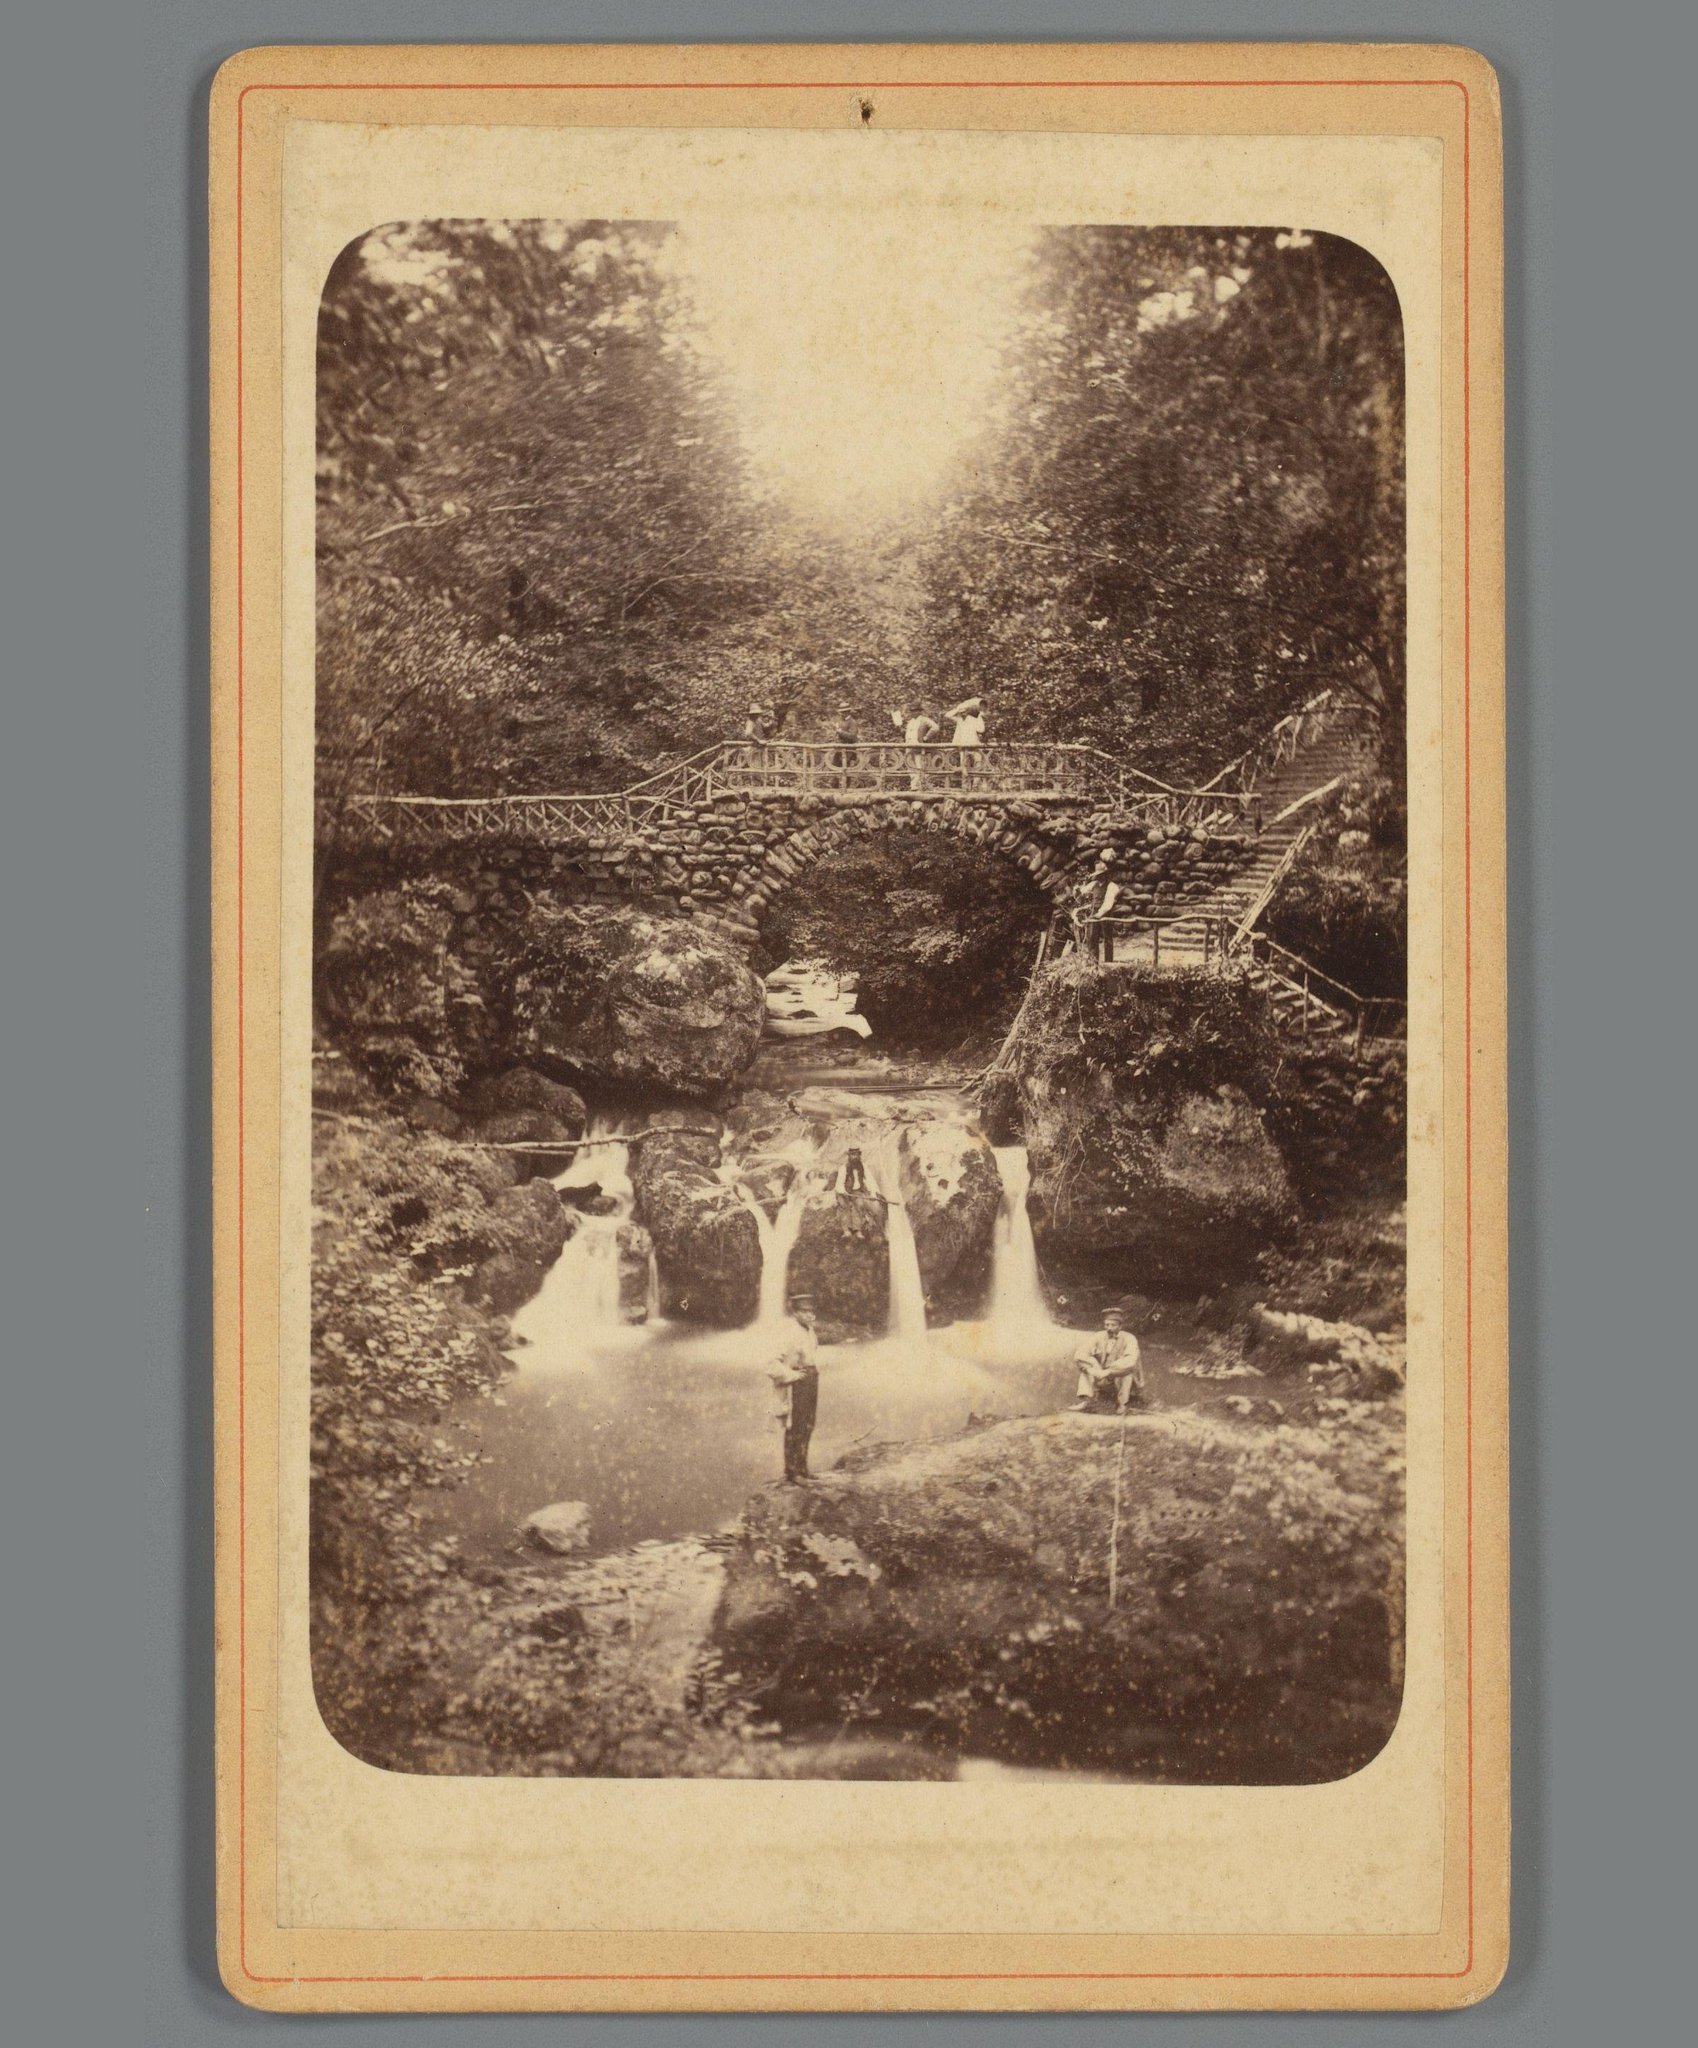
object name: cabinet photograph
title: Waterval van Schiessentümpel, Luxemburg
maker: emile thiel-pinnel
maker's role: fotograaf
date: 1866-1900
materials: cardboard, paper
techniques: albumen print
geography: müllerthal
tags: waterfall, bridge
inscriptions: inscription: ‘Cascade du Müllerthal/ Schiessentümpel’, inscription: ‘E. Thiel-Pinnel/ Photographe-Paysagiste (...) Guide des Touristes’